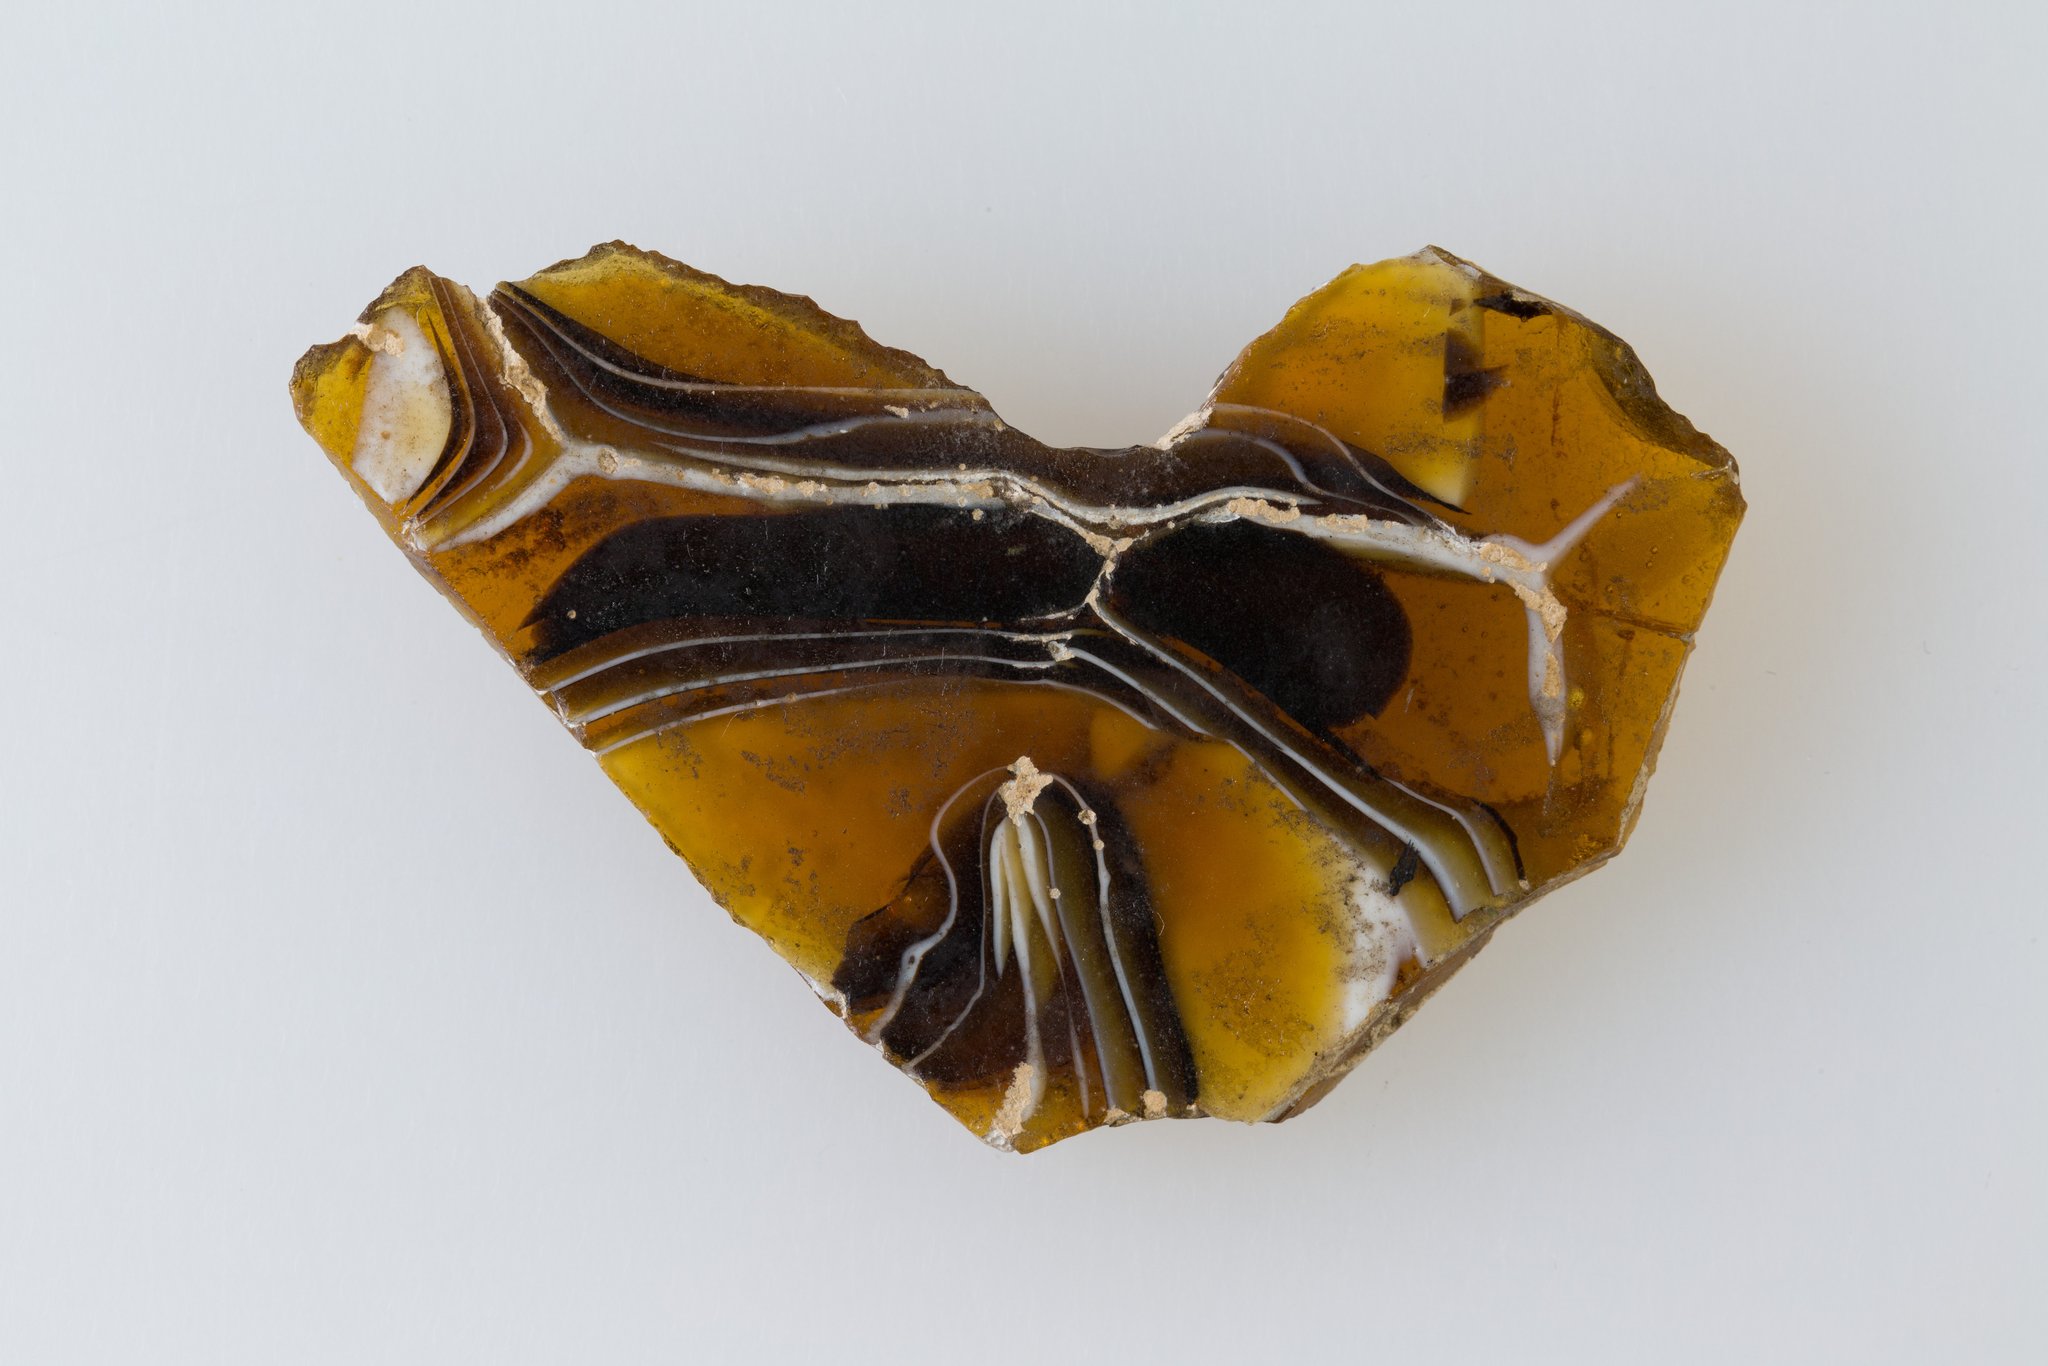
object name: wall revetment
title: Wall revetment, agate pattern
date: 200 BCE-100 CE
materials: glass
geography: egypt